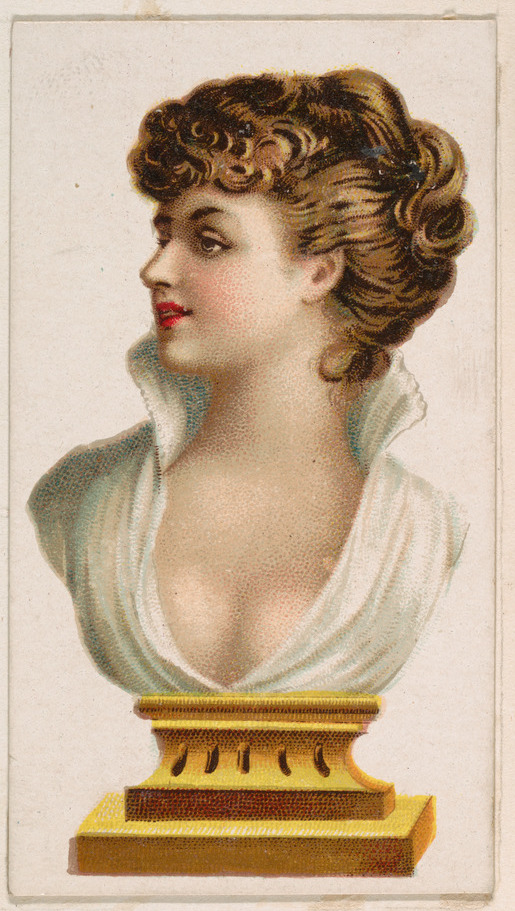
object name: print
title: Statue, from the Novelties series (N228, Type 5) issued by Kinney Bros.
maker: kinney brothers tobacco company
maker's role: publisher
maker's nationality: american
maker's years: 1869-2011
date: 1889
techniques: color lithograph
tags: women